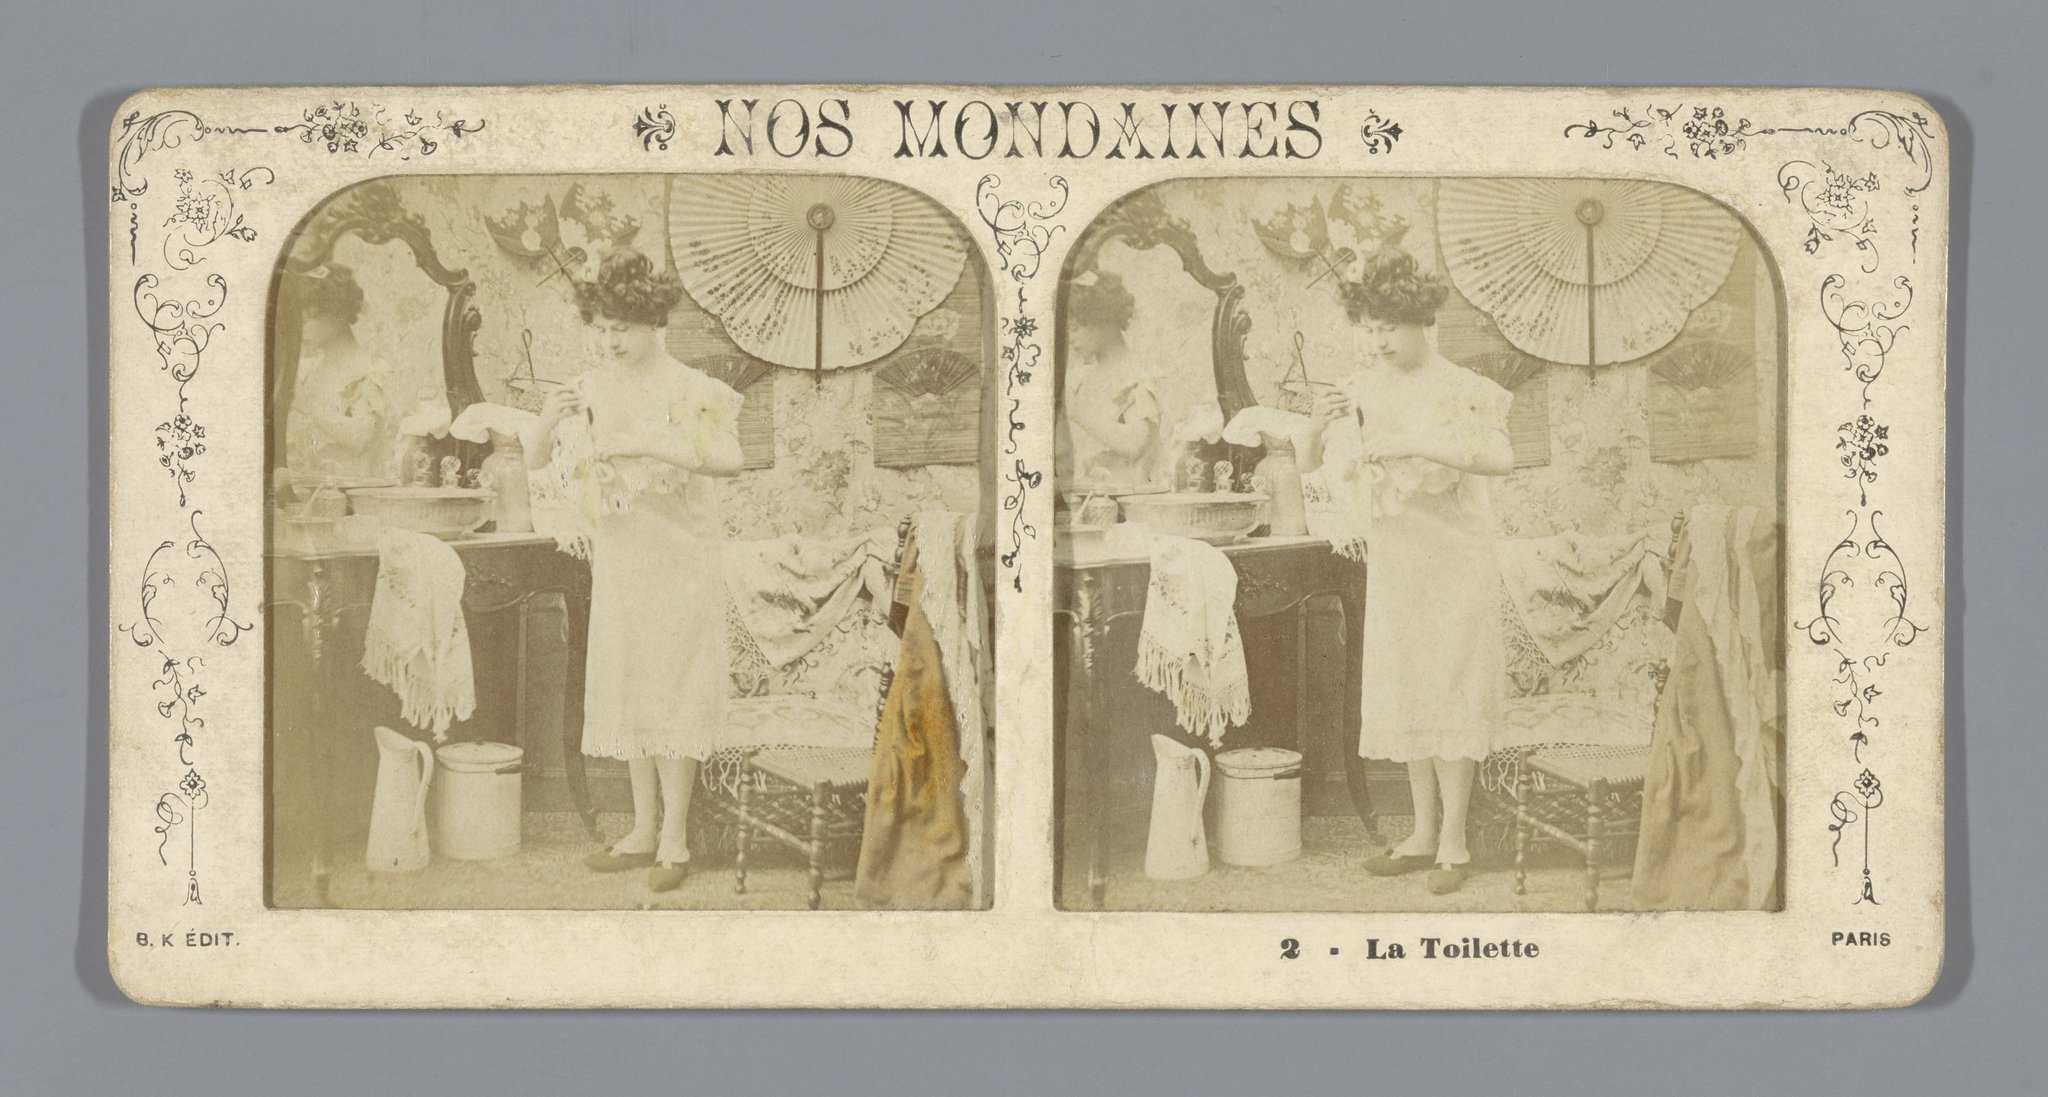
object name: tissue stereograph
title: La toilette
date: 1863-1875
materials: cardboard, paper, photographic support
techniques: albumen print, cutting, hand coloring, perforating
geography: paris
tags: making toilet - aa - (for) women, france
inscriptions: number: ‘2’